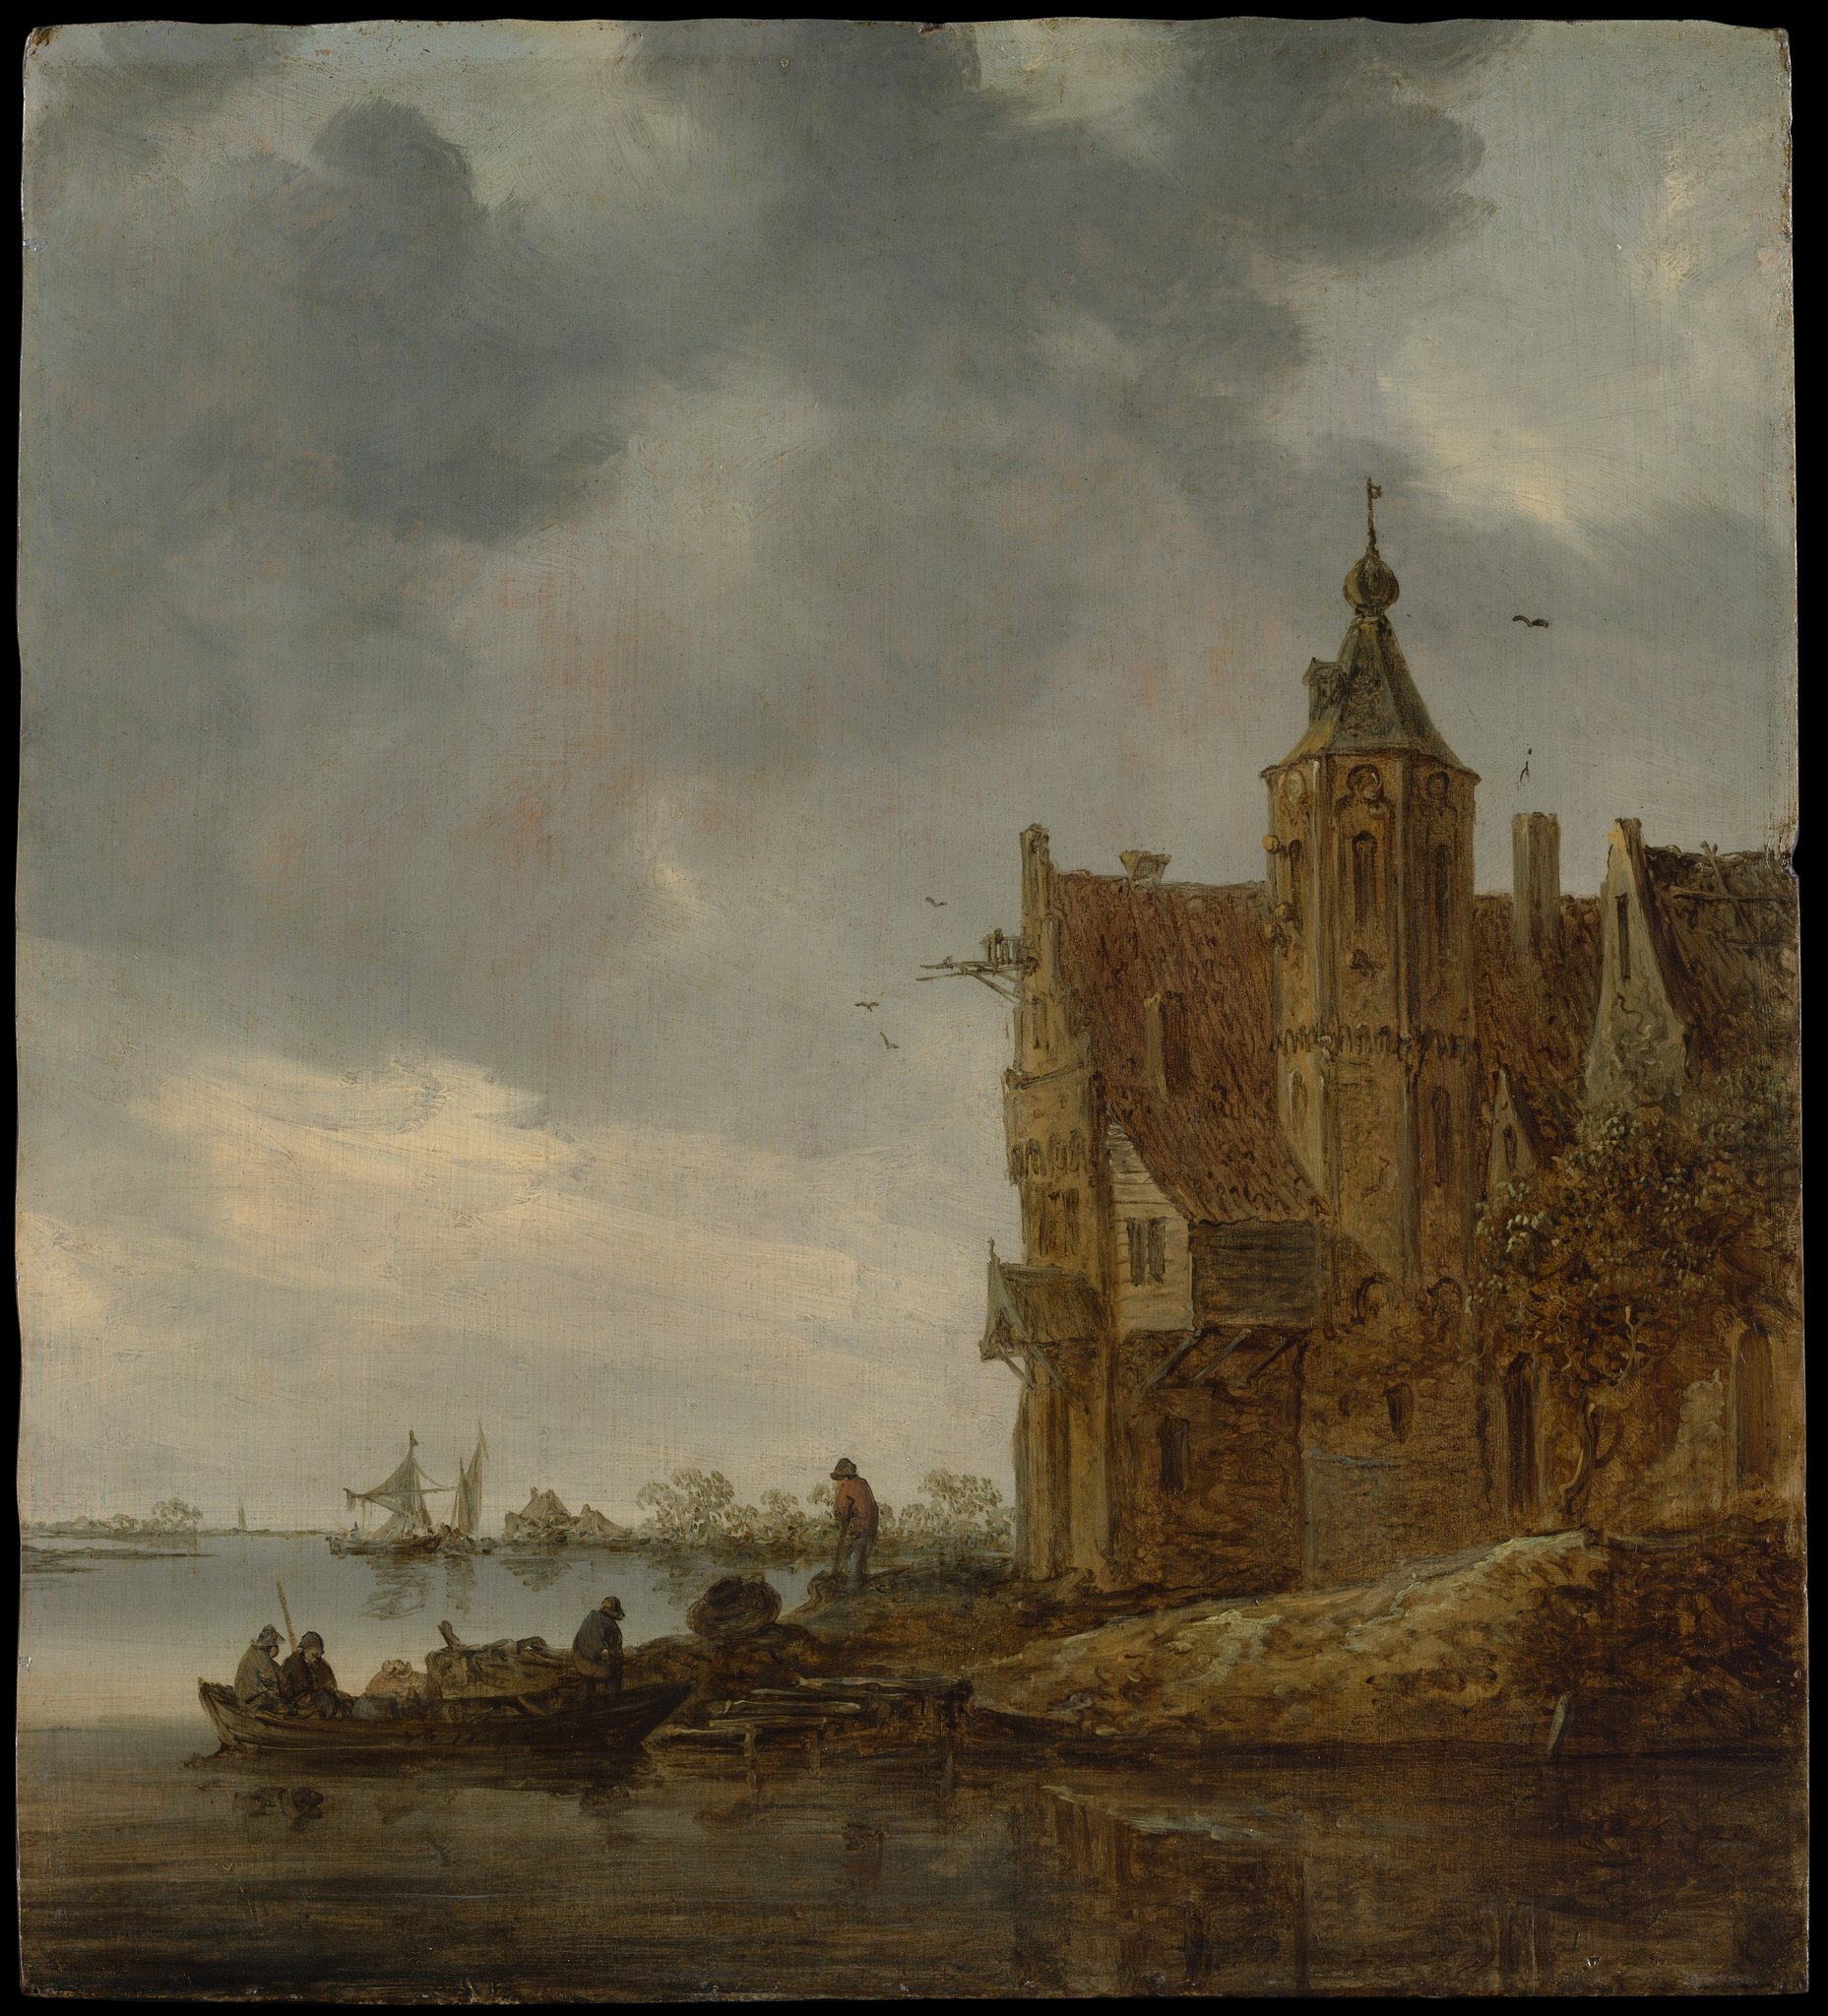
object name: painting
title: Country House near the Water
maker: jan van goyen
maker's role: artist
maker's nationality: dutch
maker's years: 1596-1656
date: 1646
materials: oil, wood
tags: houses,boats